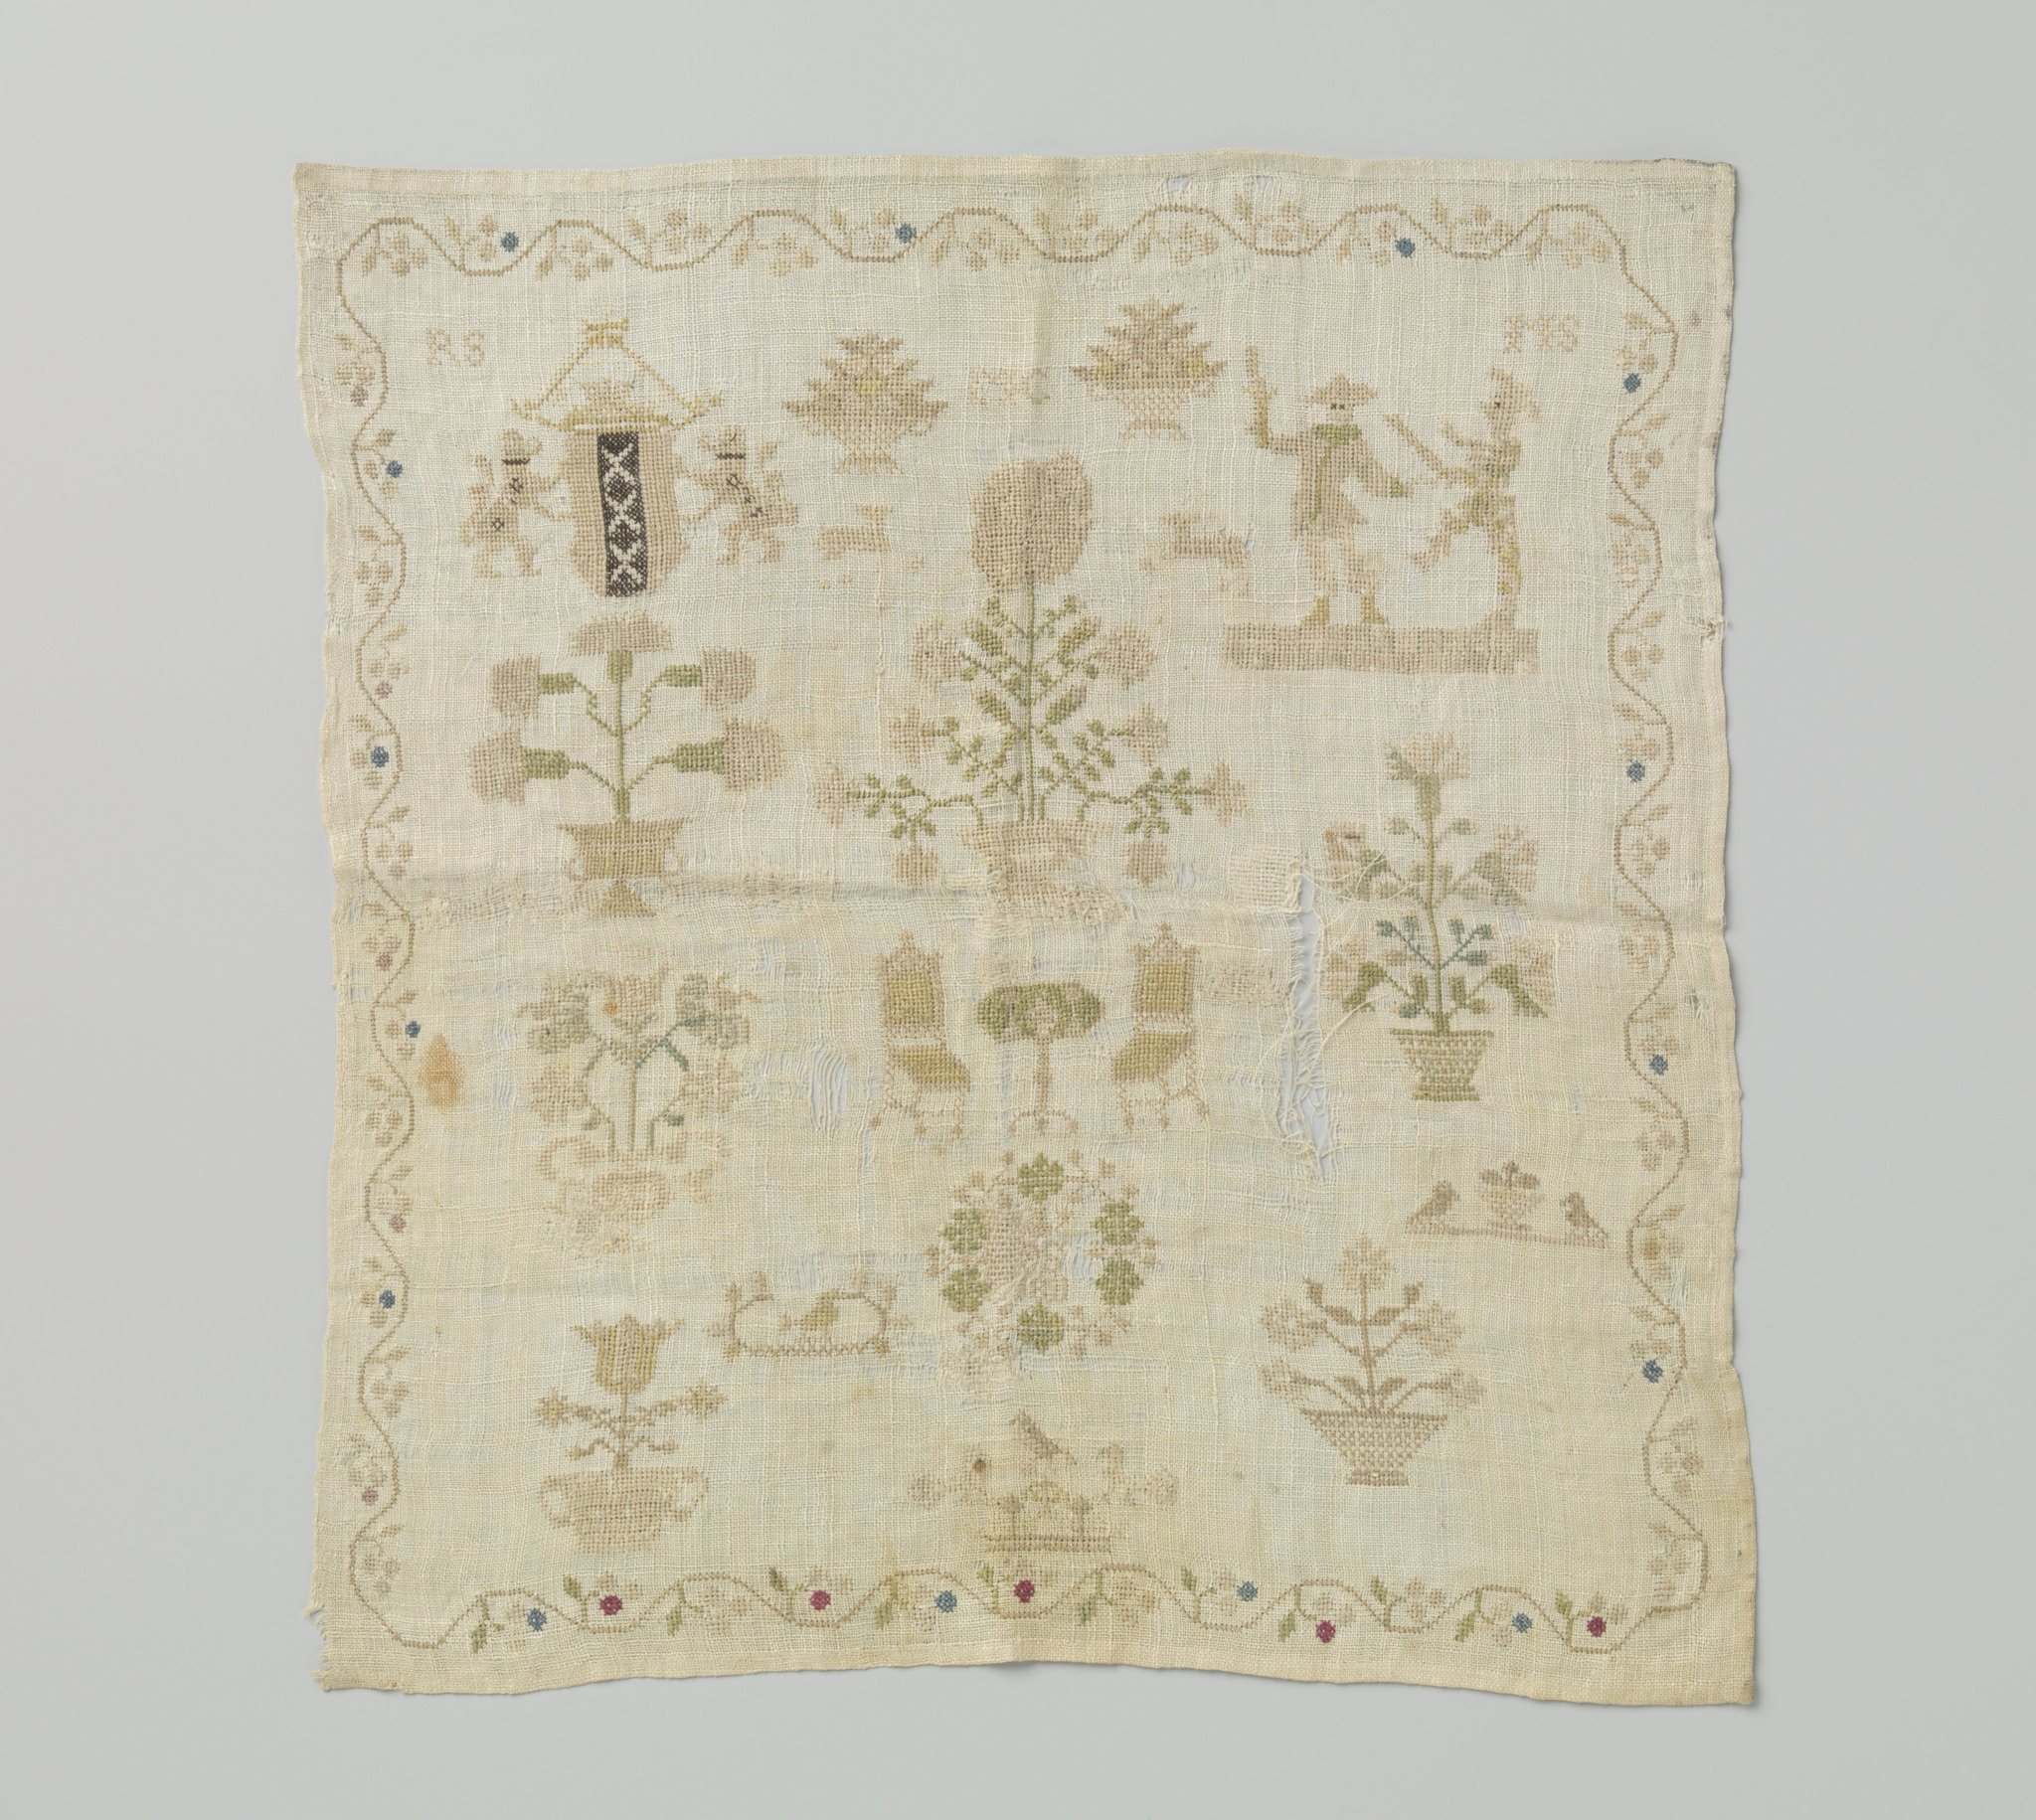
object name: merkdoek, merklap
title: Merklap met borduurwerk. Het borduurwerk heeft rechtsboven een scene uit de Commedia dell' arte en een Amsterdams wapen. Alle hoeken hebben verschillend borduurwerk.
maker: Anonymous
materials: linen, silk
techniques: embroidered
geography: burgerweeshuis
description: Merklap met borduurwerk. Het borduurwerk heeft rechtsboven een scene uit de Commedia dell' arte en een Amsterdams wapen. Alle hoeken hebben verschillend borduurwerk.